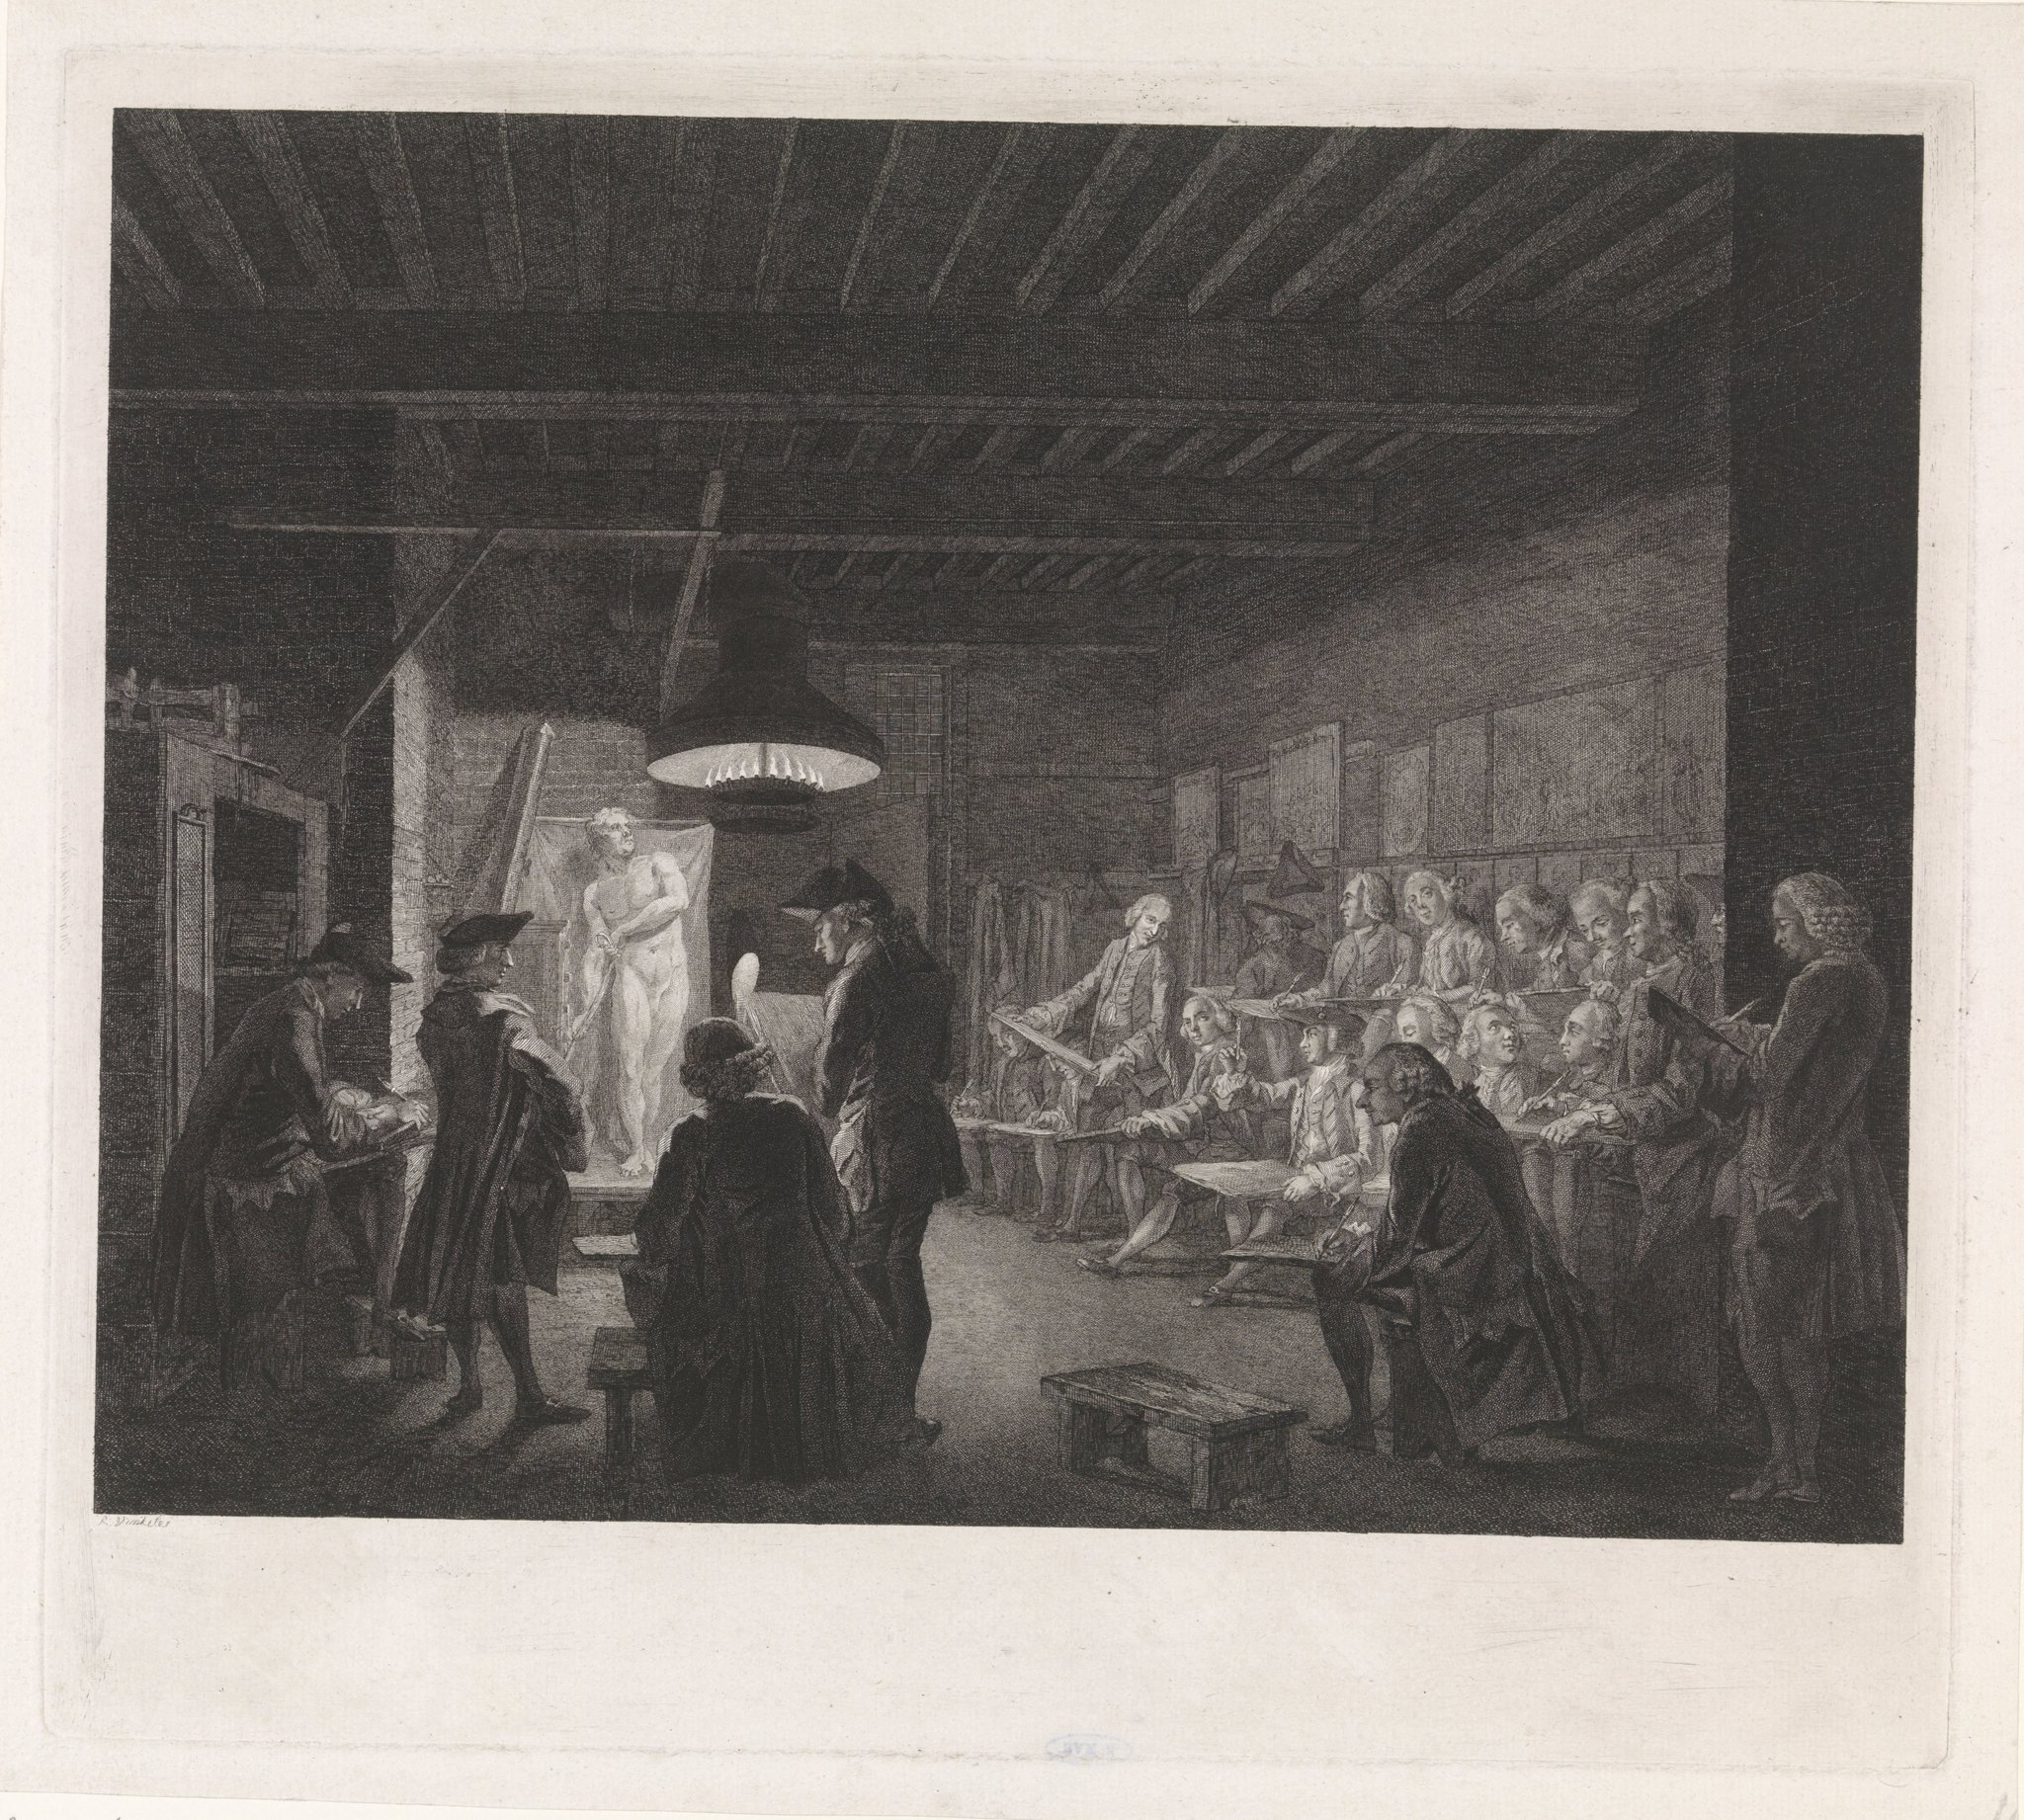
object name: print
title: Stadstekenacademie te Amsterdam, 1764-1767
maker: reinier vinkeles (i)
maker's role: draughtsman, print maker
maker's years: 1741-1816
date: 1768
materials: paper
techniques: engraving, etching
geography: northern netherlands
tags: drawing-lesson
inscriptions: collector's mark: Lugt 2228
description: De stadstekenacademie (Teeken-Academie) boven het Corps de Garde in de Leidsepoort te Amsterdam in het jaar 1764. De tekenacademie verhuisde op 4 december 1767 naar het stadhuis op de Dam. Een groep mannelijke tekenleerlingen in een vrij donker interieur bij lamplicht tekenend naar een mannelijk naaktmodel, het model staand van voren gezien. Met leeg marge onderaan.